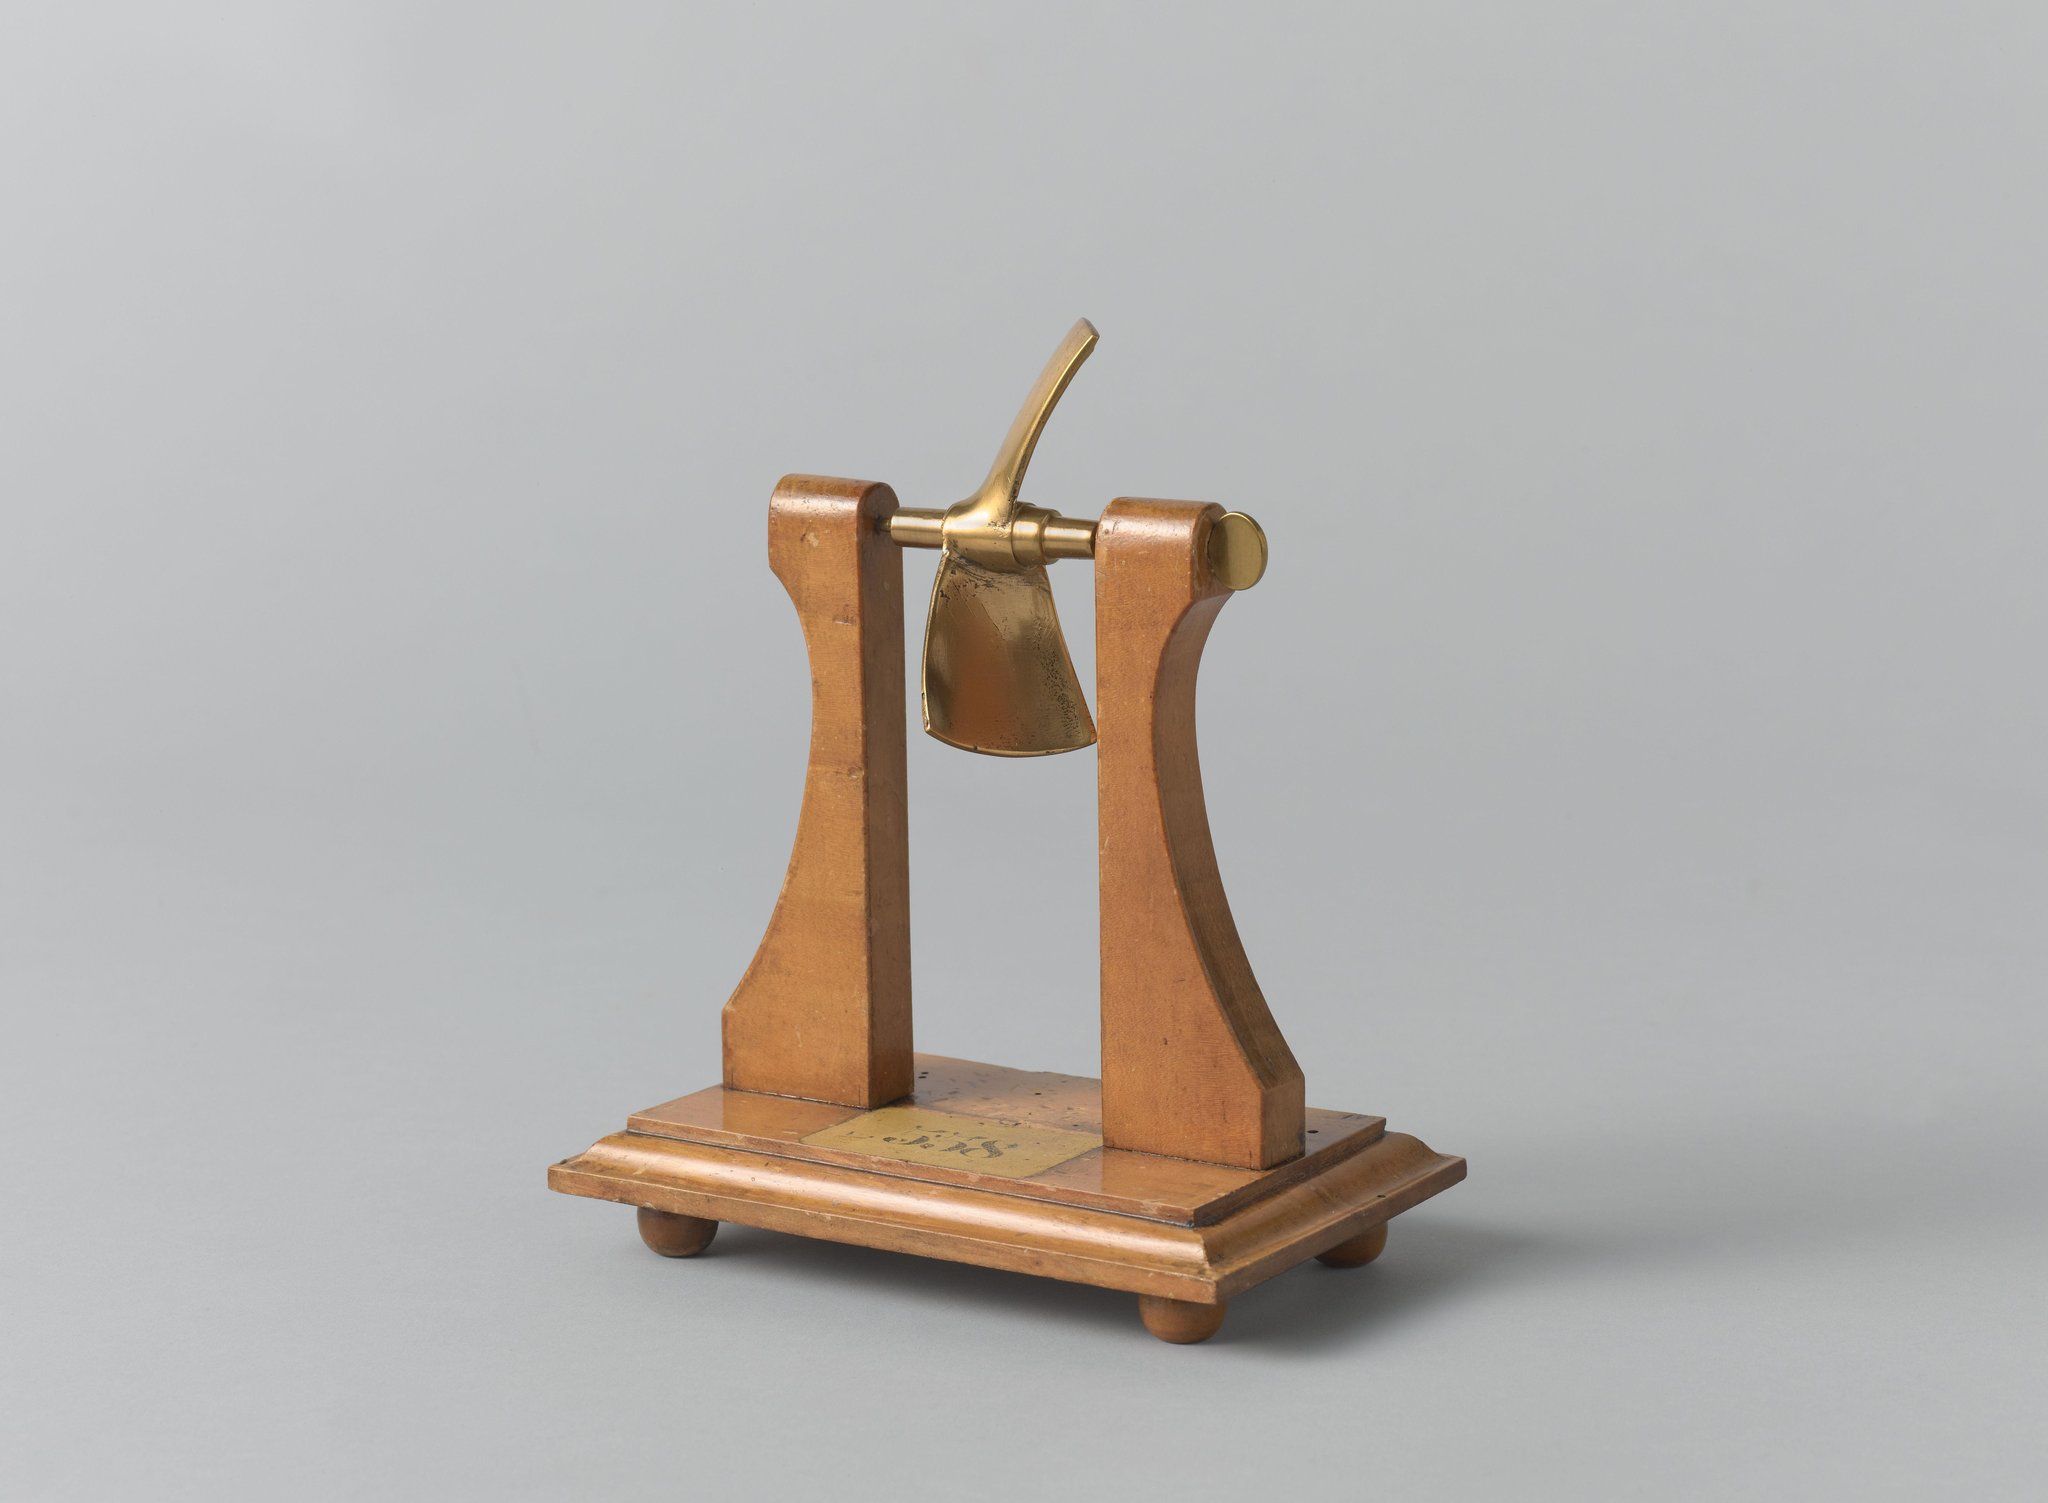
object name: presentation model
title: Model of a Two-Blade Parabolic Propeller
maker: Anonymous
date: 1844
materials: brass, wood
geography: united kingdom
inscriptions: label, on the base: ‘558’ former inventory label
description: Model van een tweebladige parabolische schroef in een frame op een grondplank. Het drukvlak van de schroefbladen is gebogen in de vorm van een parabool. De schroef hoort waarschijnlijk niet in dit frame, waar een veel grotere schroef in kan. Het model heeft een diameter van 85 mm, de naaf heeft een diameter van 8 mm en is waarschijnlijk te lang in verhouding tot de ware grootte, om in het frame te passen. Schaal 1:20 (afgeleid).